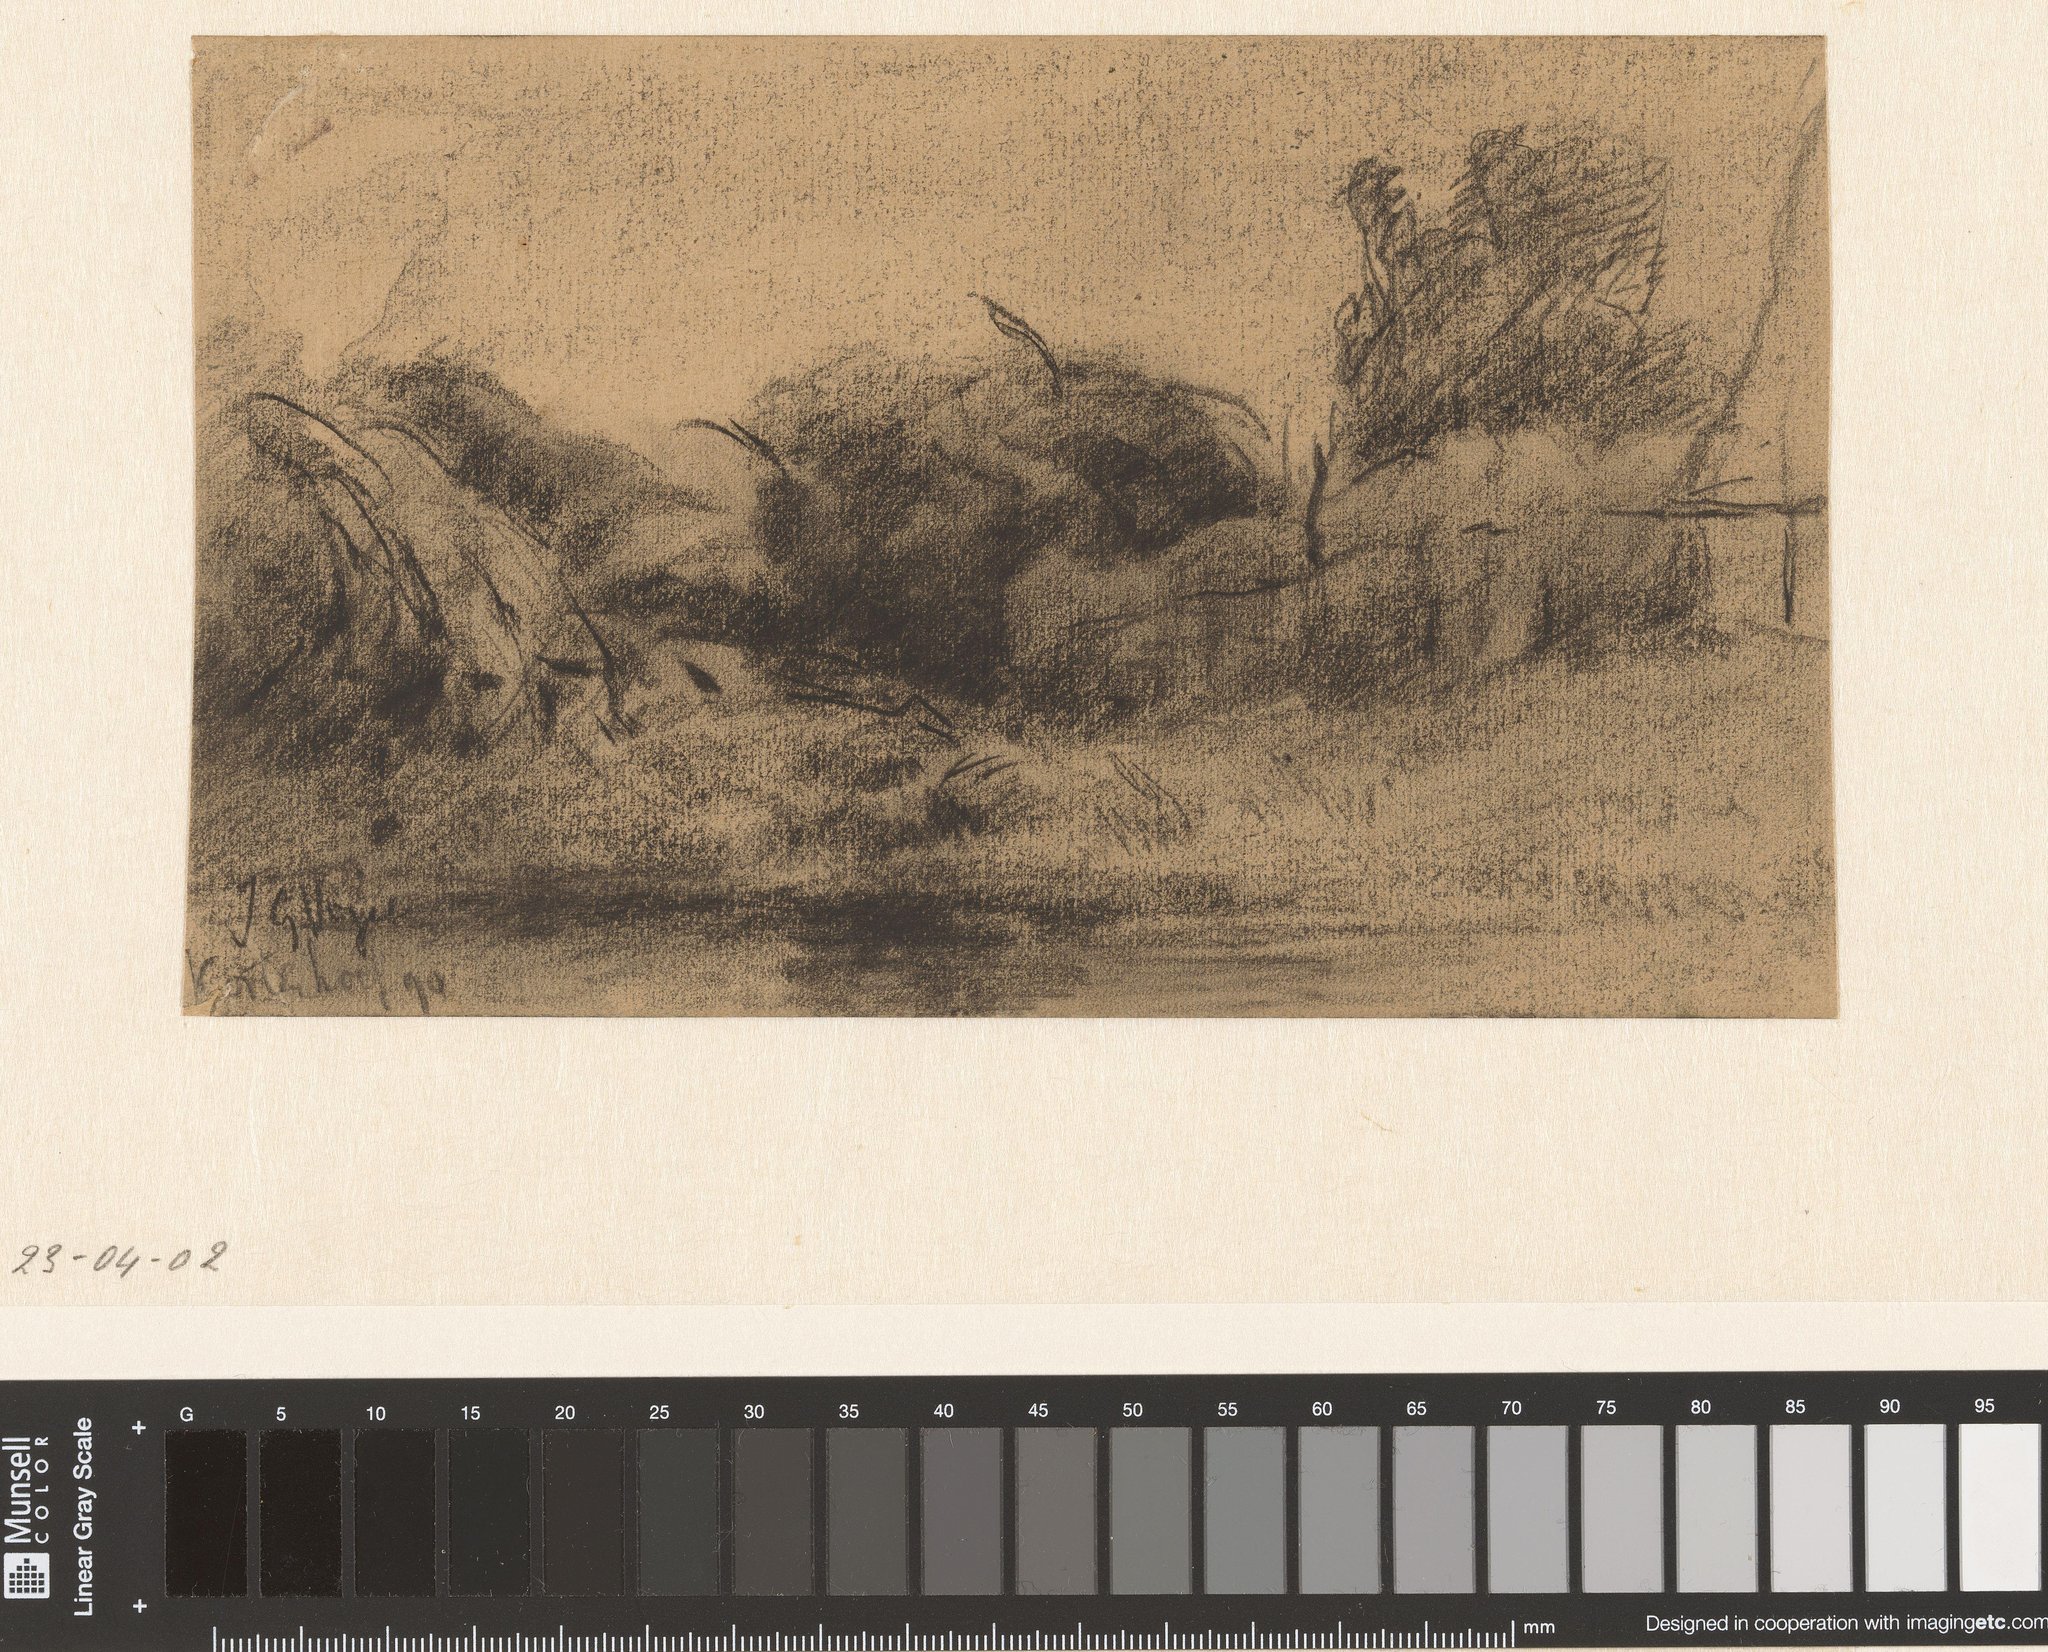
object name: drawing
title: Landschap bij Kortenhoef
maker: johannes gijsbert vogel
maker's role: draughtsman, painter, print maker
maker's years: 1828-1915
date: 1890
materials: chalk, paper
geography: kortenhoef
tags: landscapes